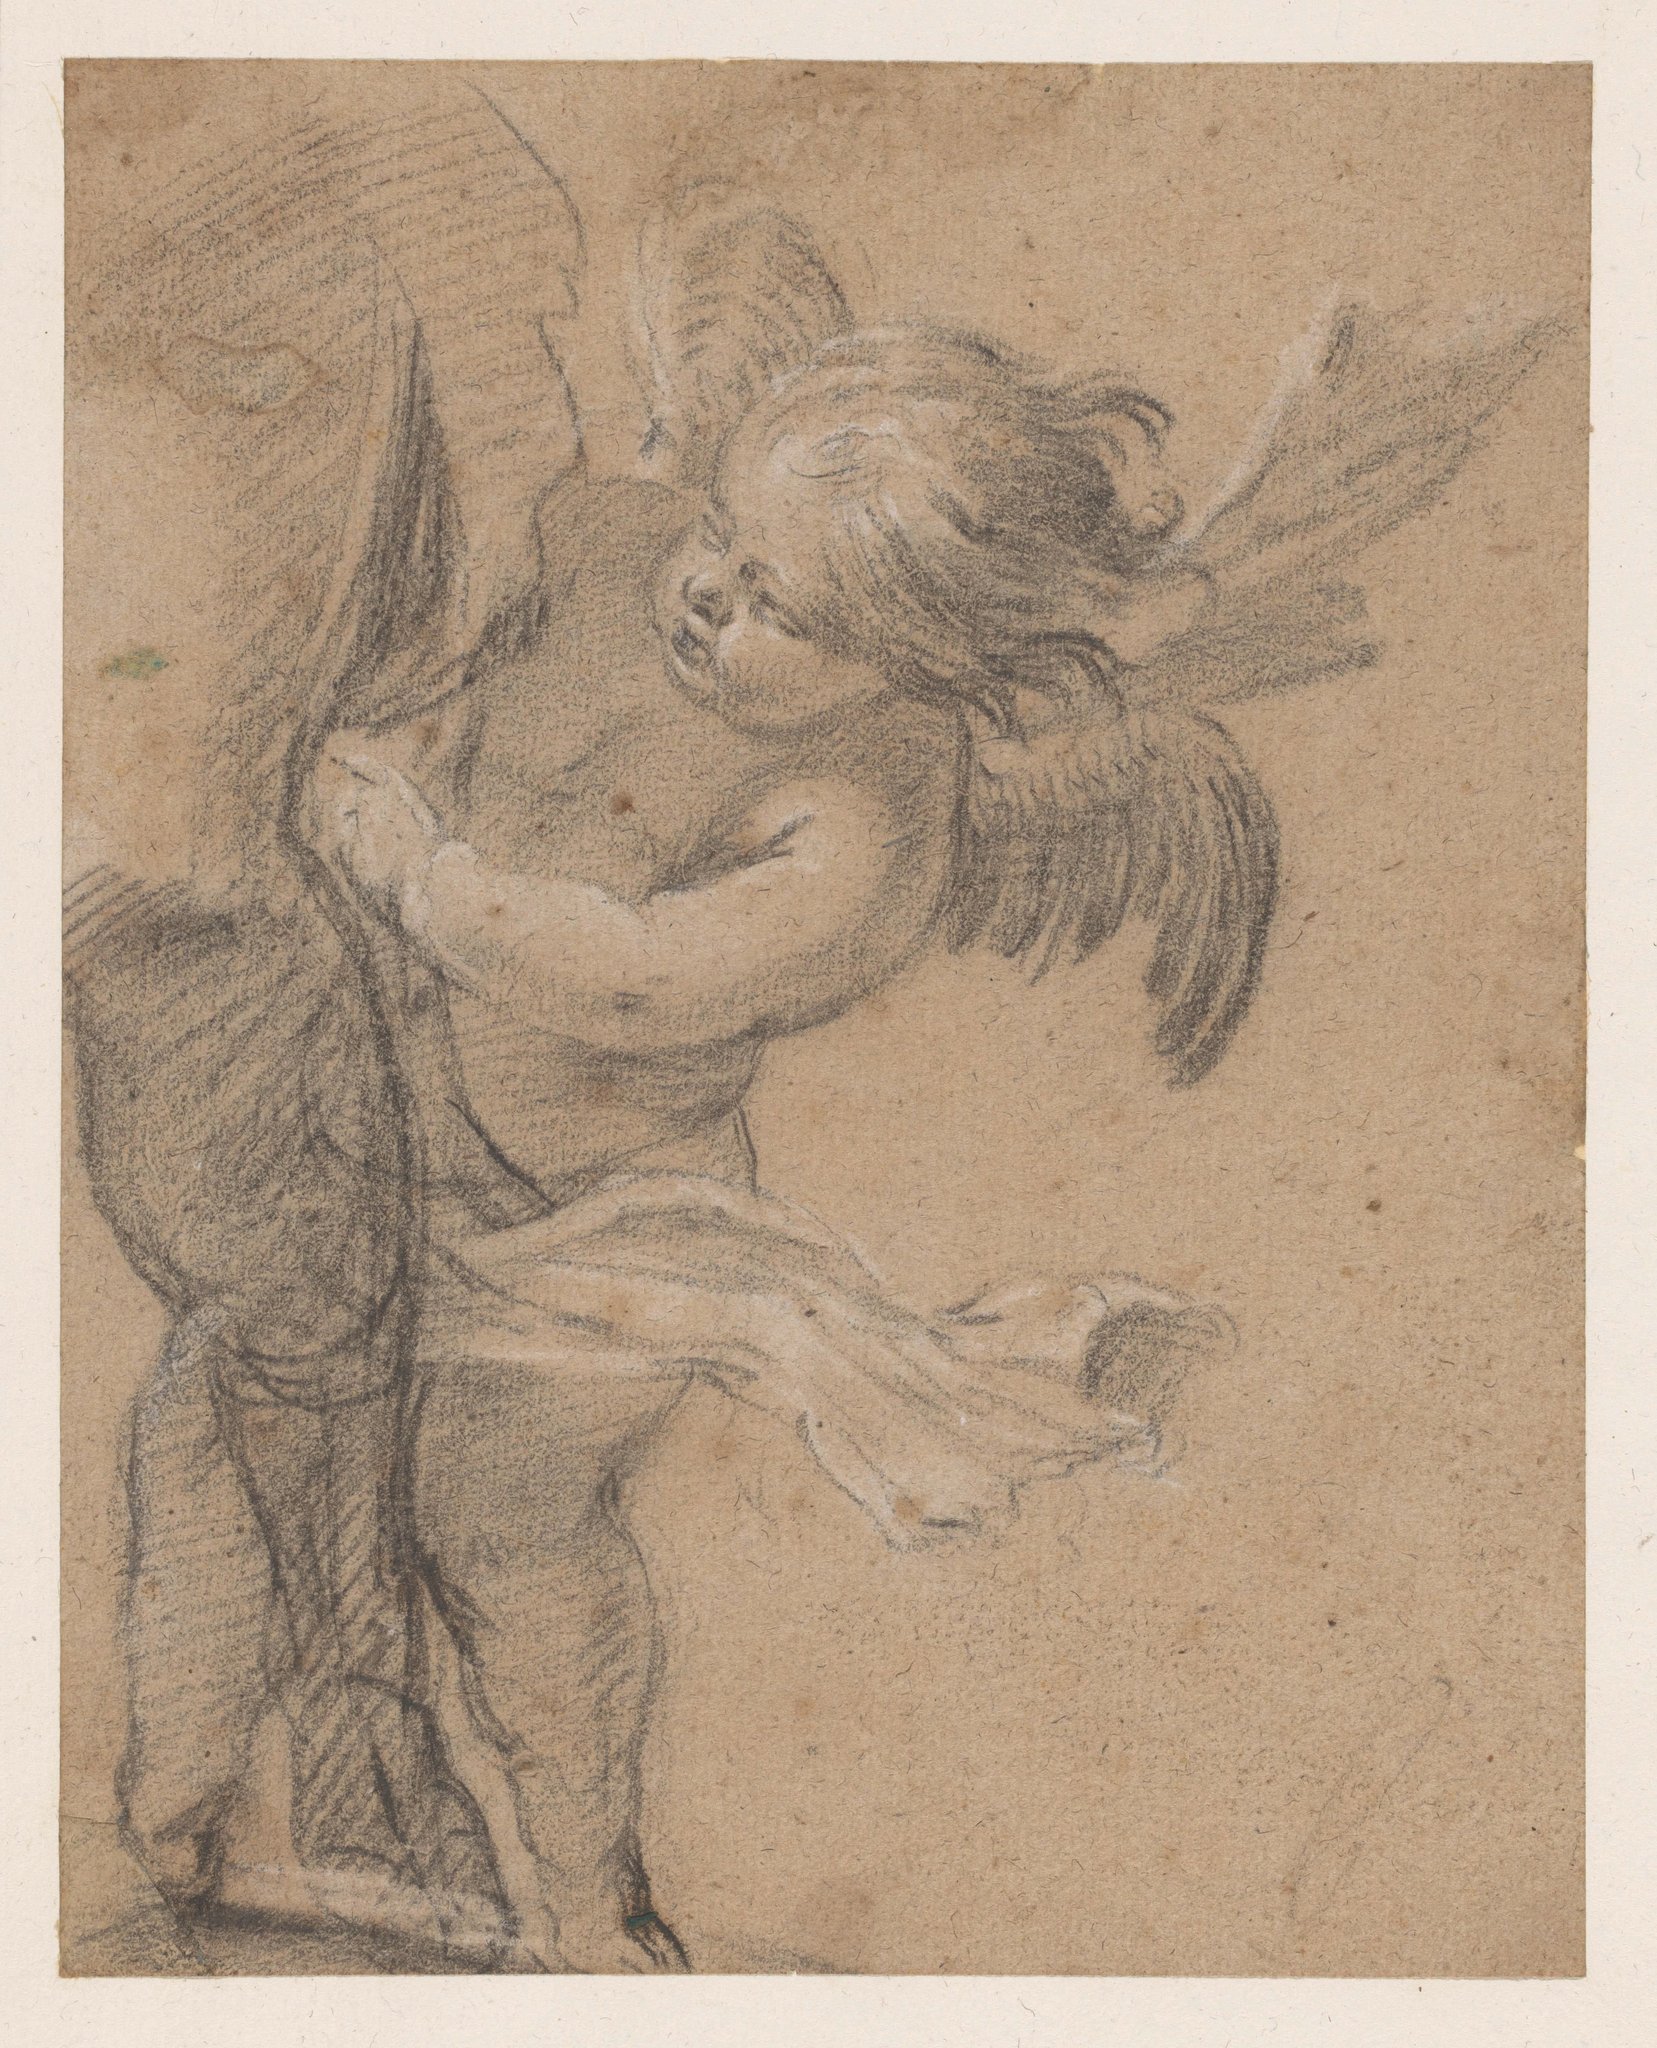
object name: drawing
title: Engeltje bij het been van de H. Rochus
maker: simon vouet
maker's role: draughtsman, print maker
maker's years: 1590-1649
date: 1600-1659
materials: chalk, paper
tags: the confessor and pilgrim roch(us) (rocco, rock) of montpellier; possible attributes: angel (with ointment box or spoon), dog (sometimes with loaf), (pointing at) plague-spot on thigh, pilgrim's shell, staff, hat and wallet